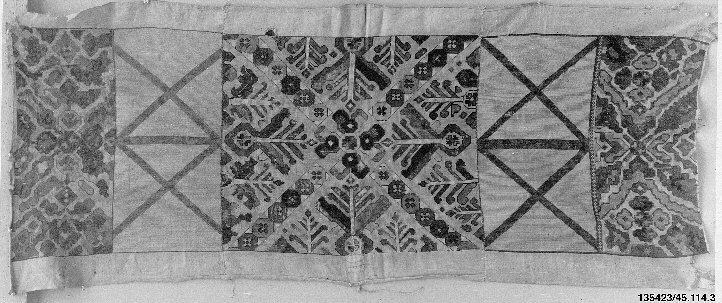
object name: strip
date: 1701-1800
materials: linen, silk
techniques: embroidery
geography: morocco